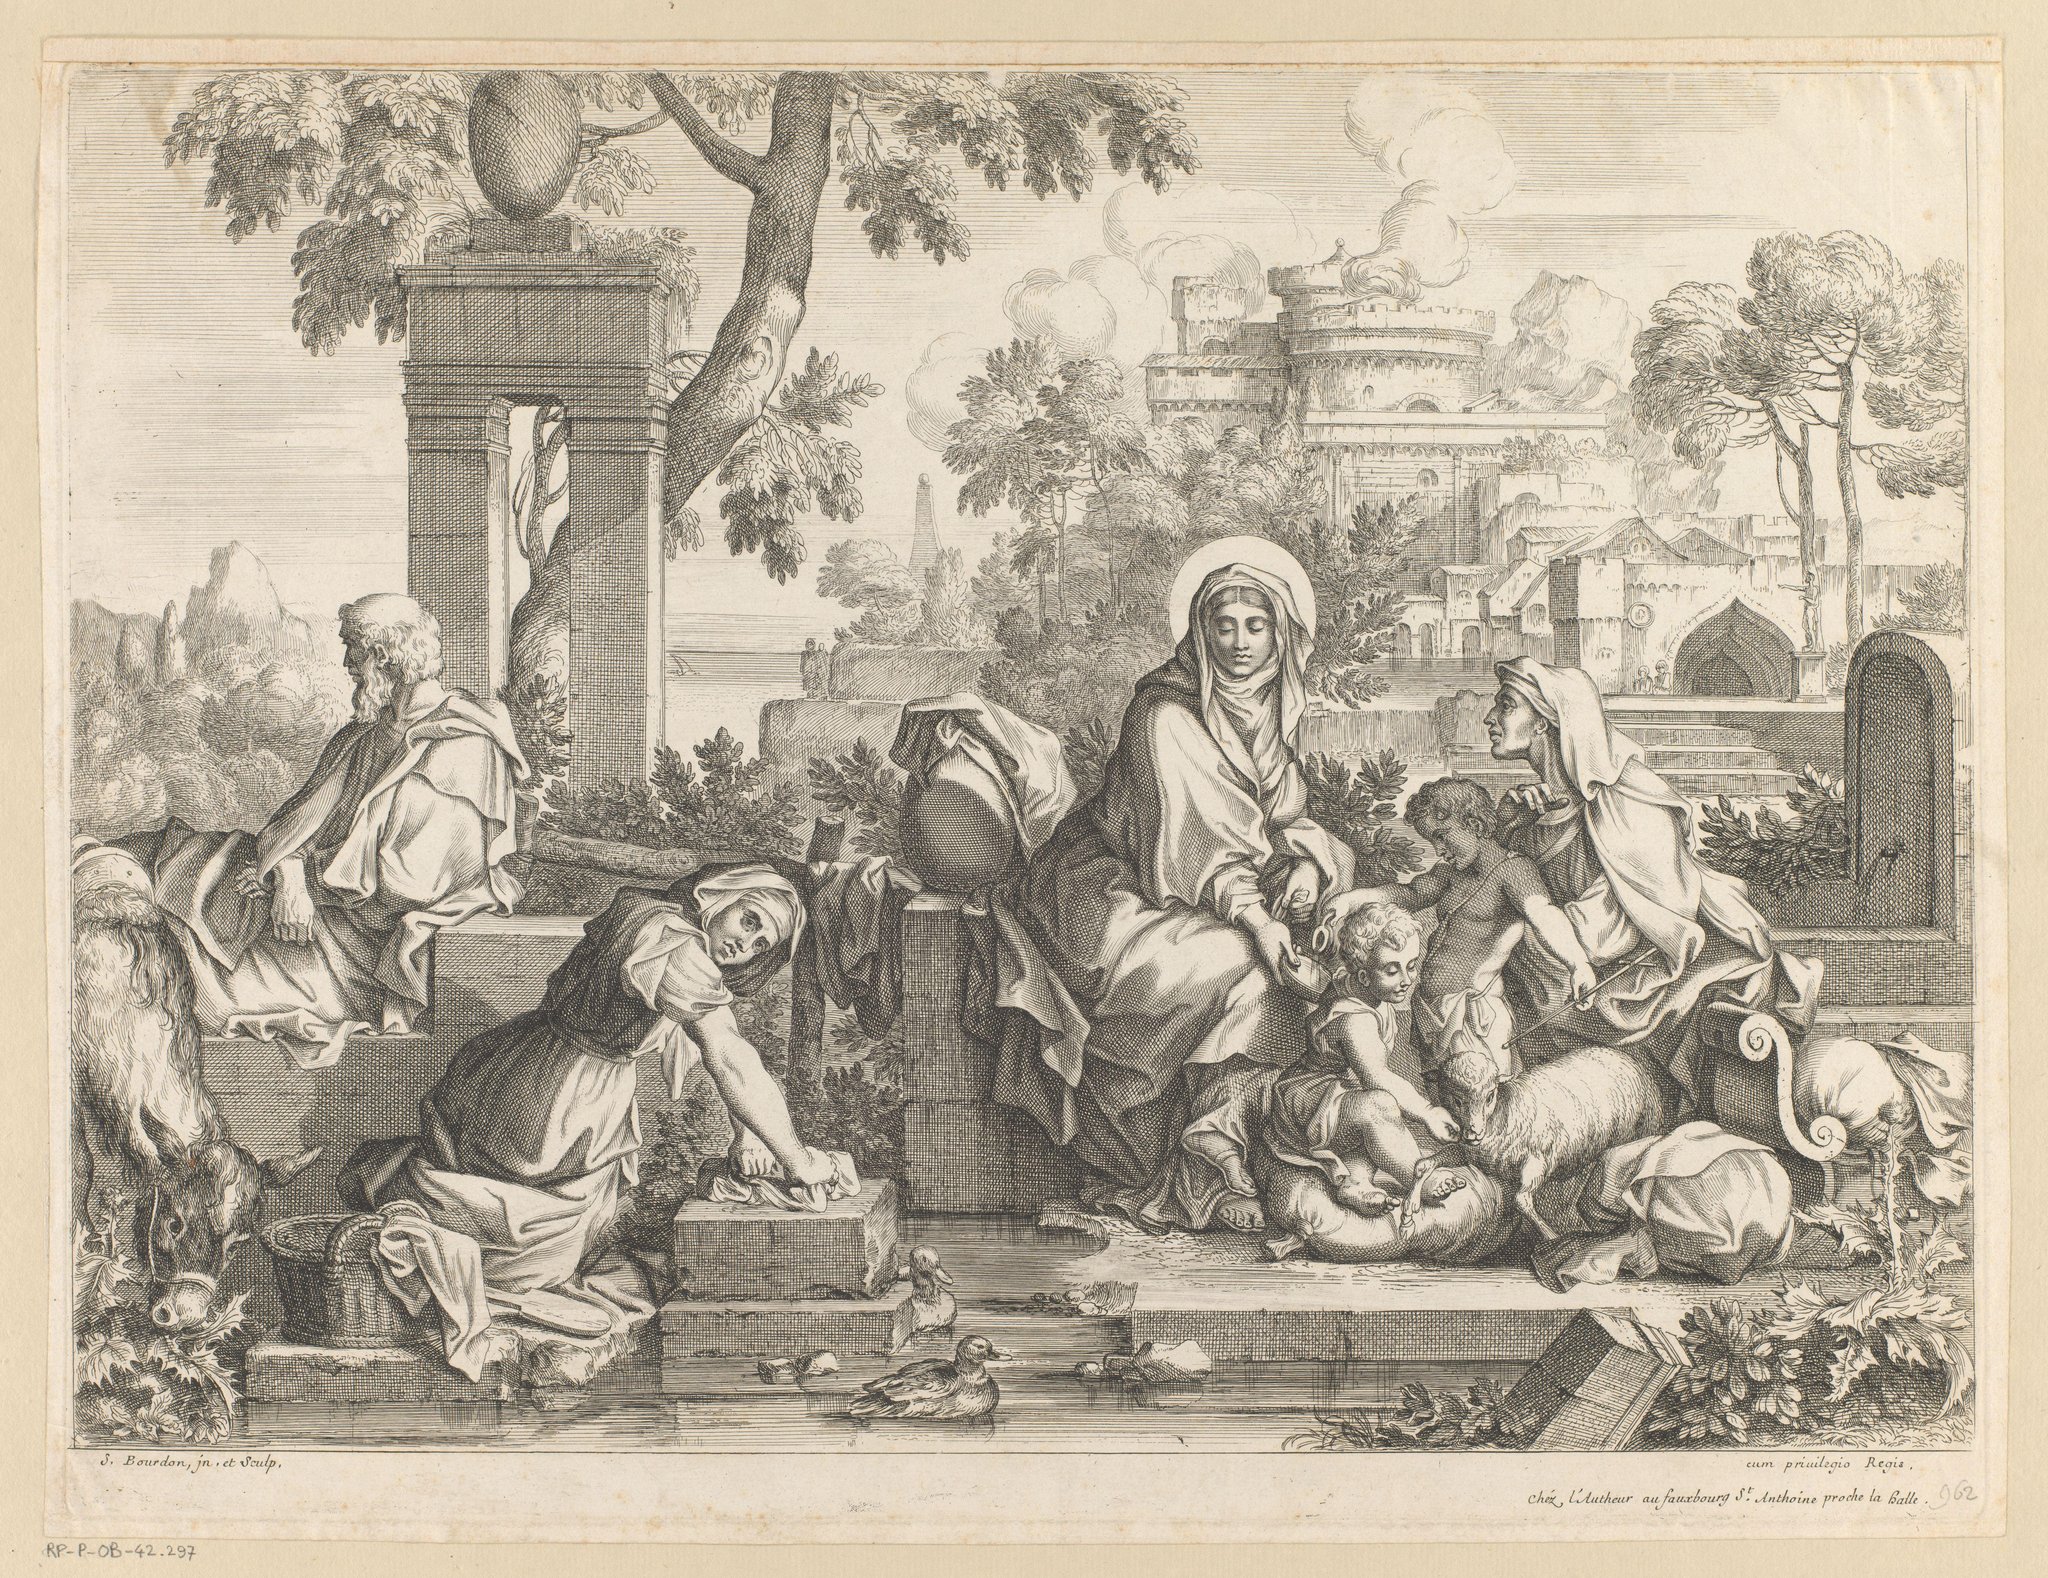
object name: print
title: Heilige Familie bij de wasplaats met Elizabeth en Johannes de Doper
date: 1626-1671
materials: paper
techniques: engraving, etching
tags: holy family with john the baptist, elisabeth present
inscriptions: collector's mark: Lugt 240